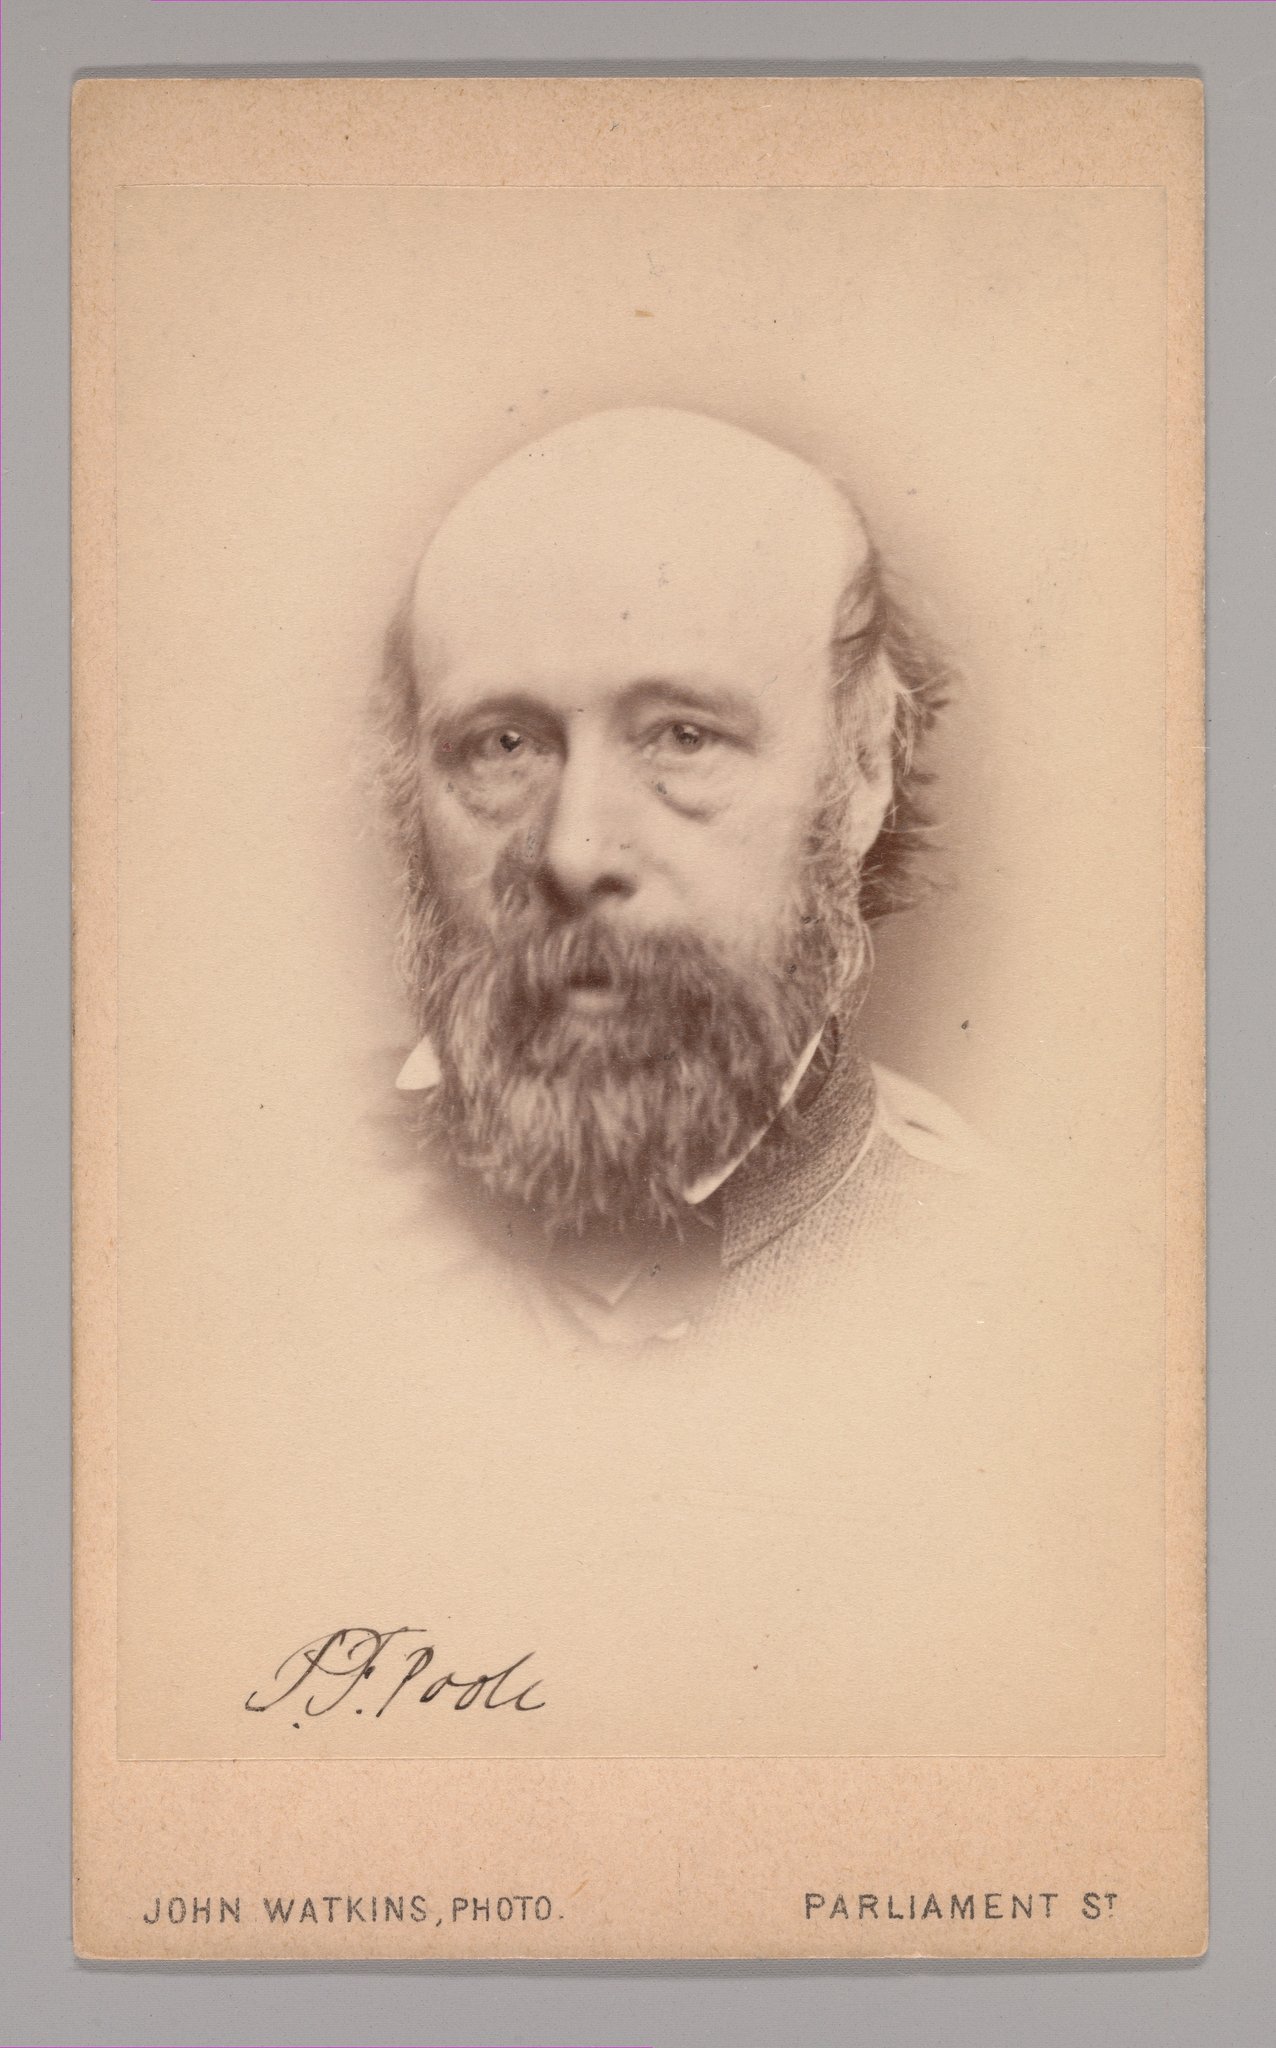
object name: carte de visite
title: [Paul Falconer Poole]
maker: john and charles watkins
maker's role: photography studio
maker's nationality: british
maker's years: 1840-1875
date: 1860-1869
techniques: albumen silver print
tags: men,portraits